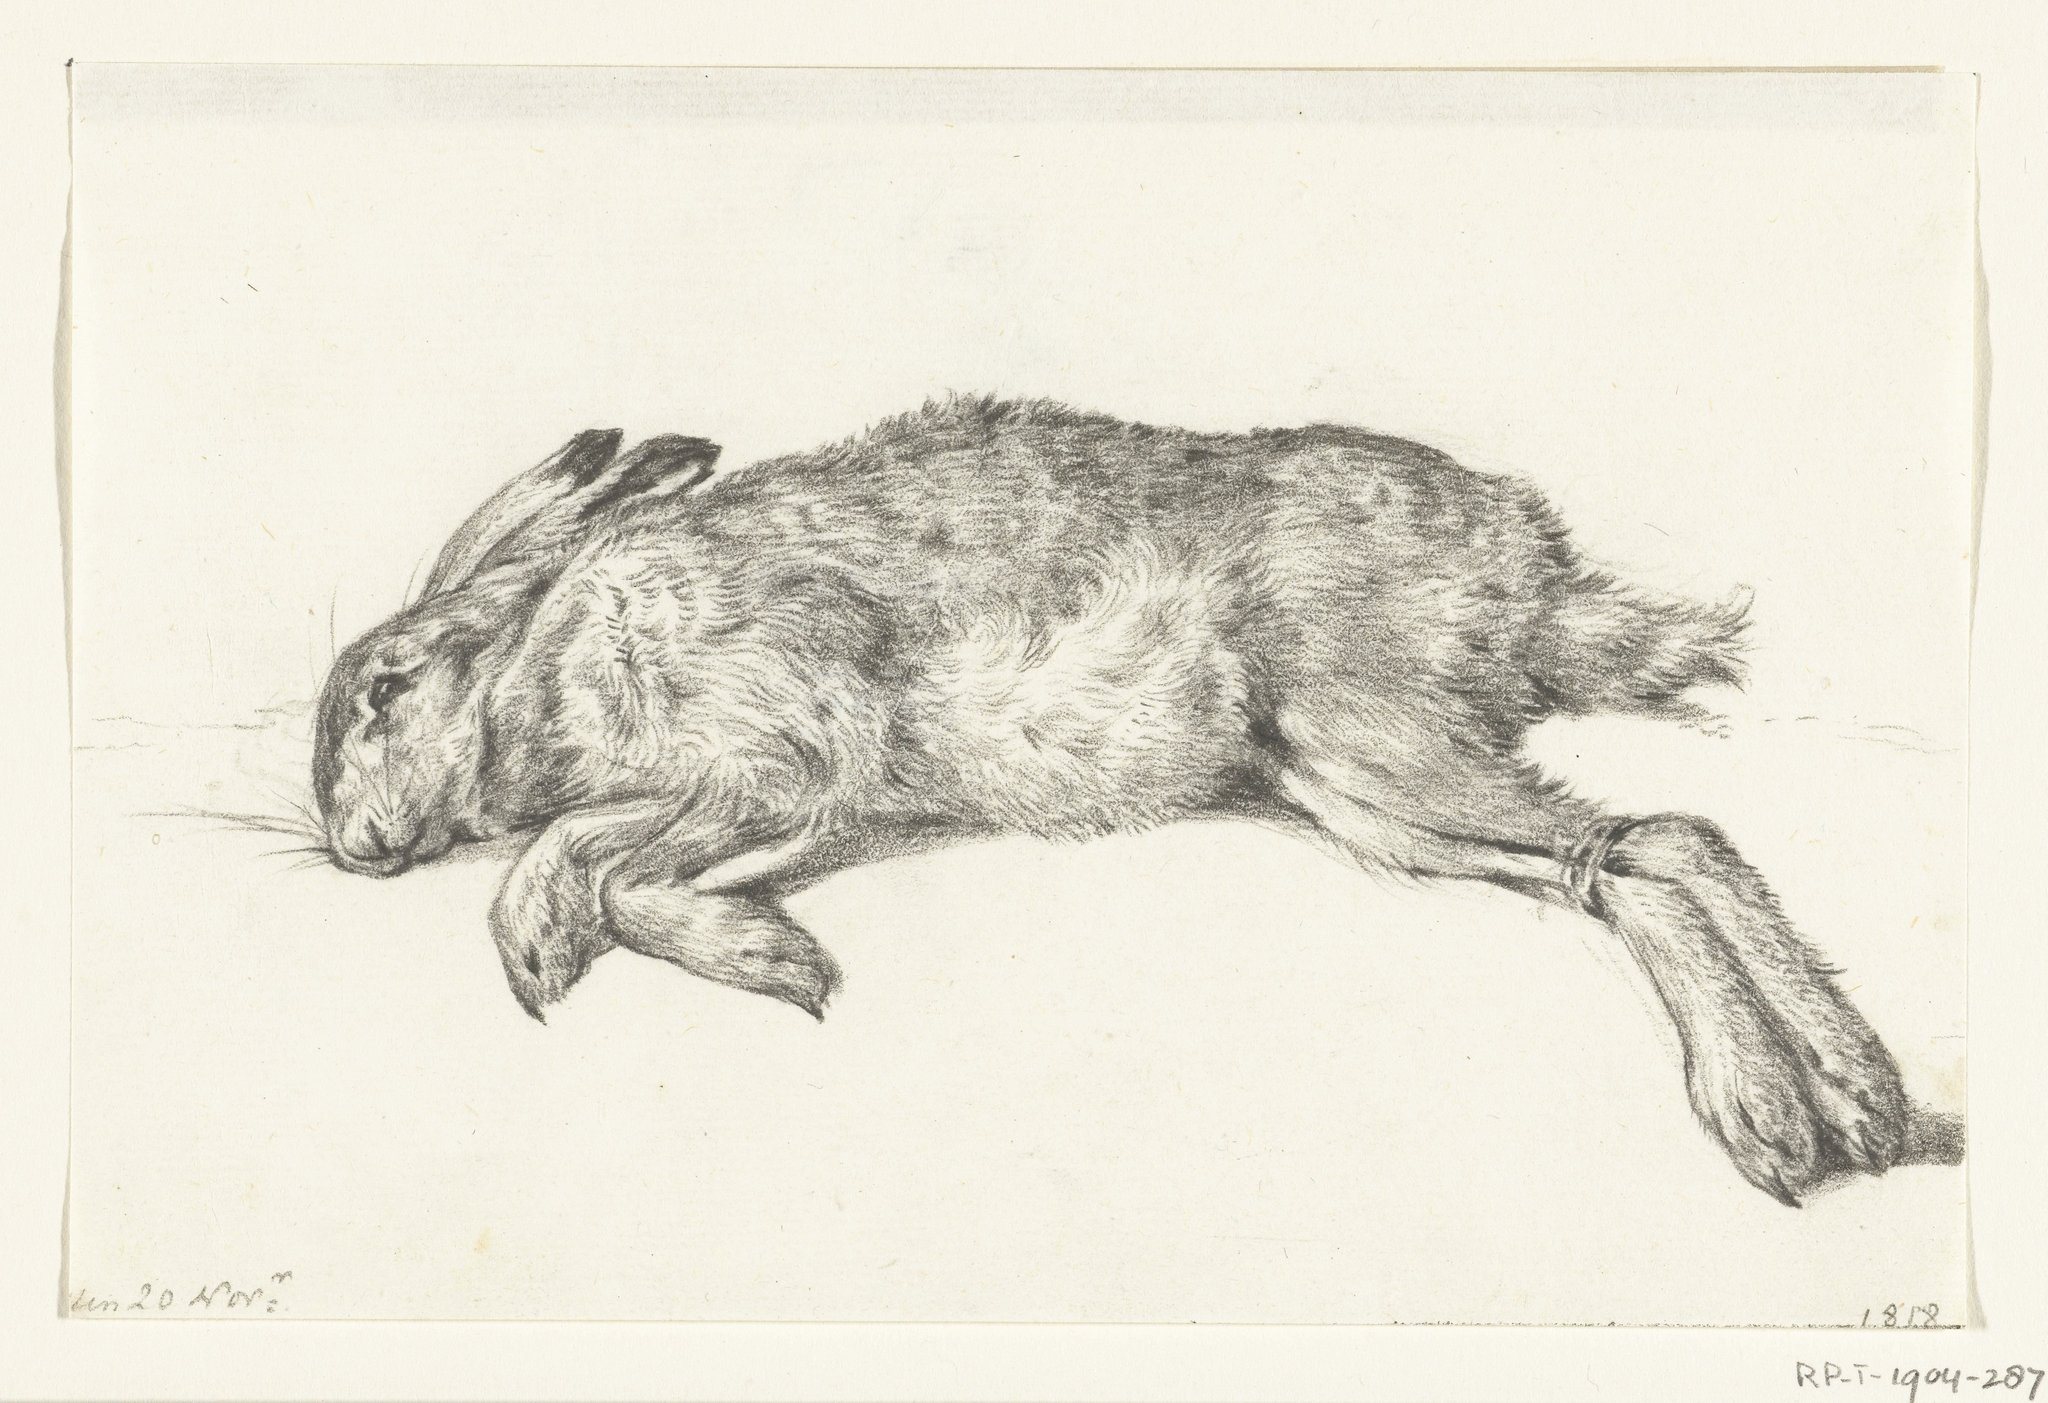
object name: drawing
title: Liggende dode haas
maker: jean bernard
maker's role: draughtsman, print maker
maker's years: 1765-1833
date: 1818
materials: chalk, paper, pencil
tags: rodents: hare